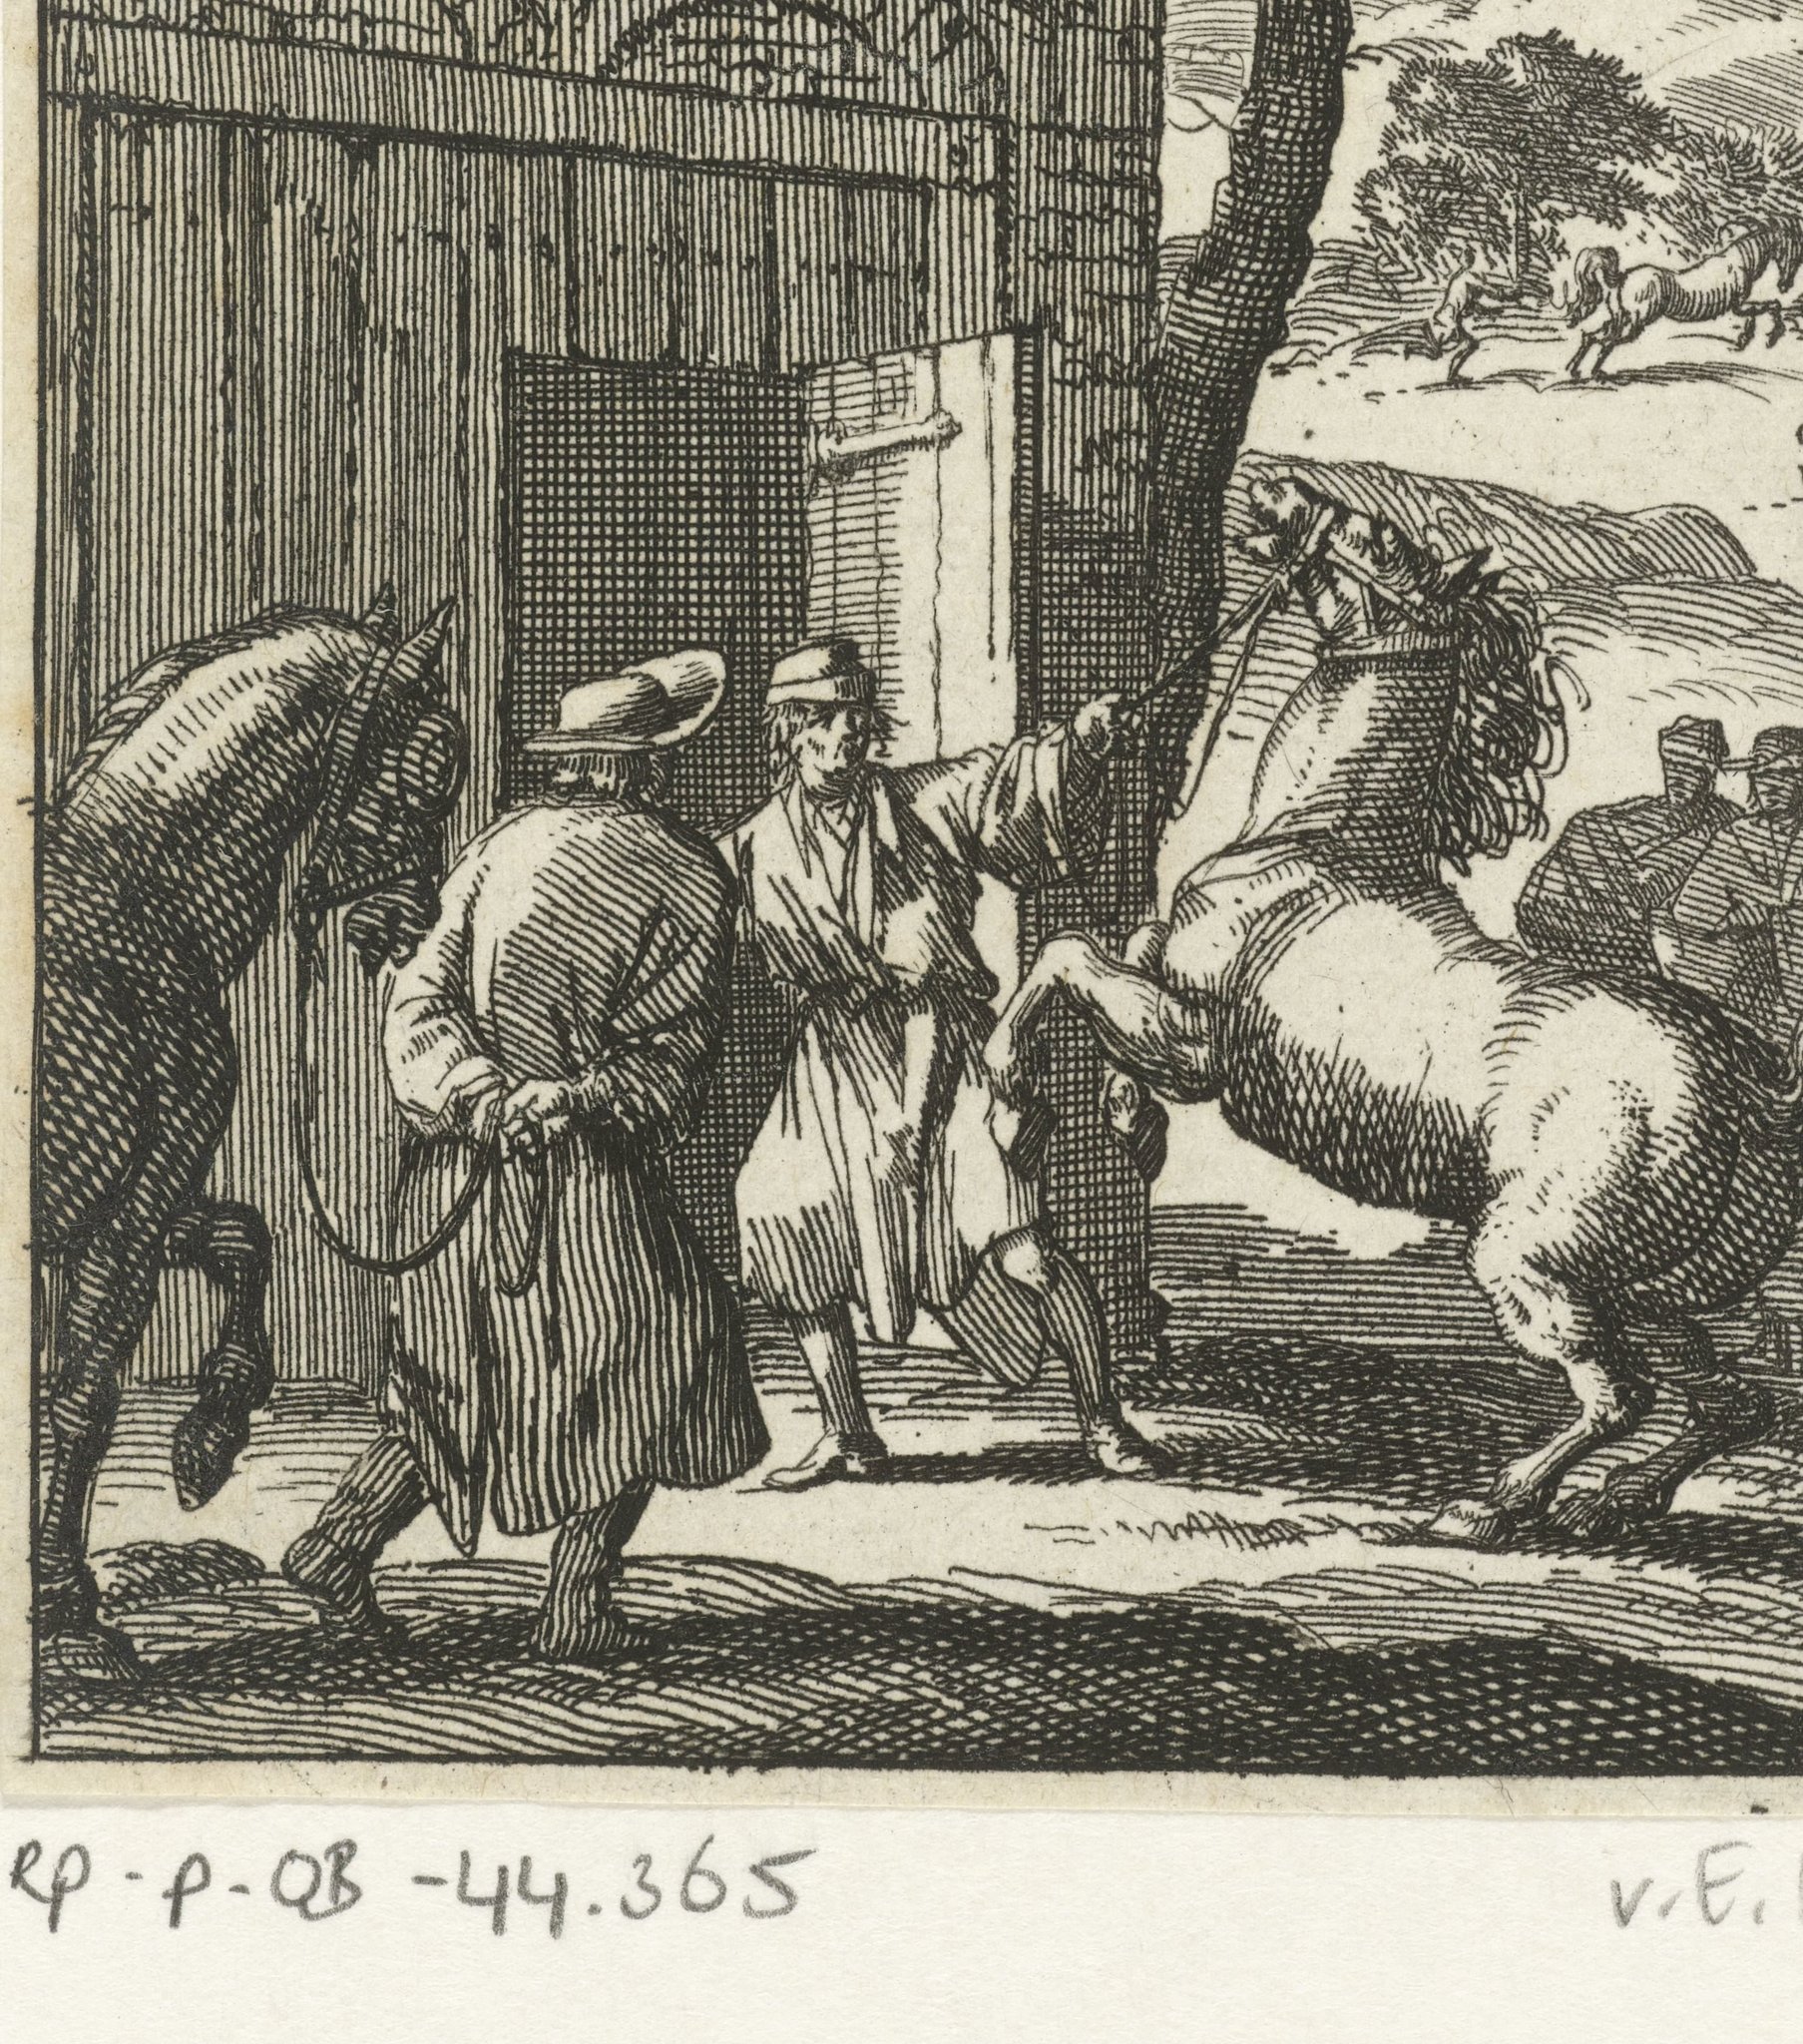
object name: print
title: Man houdt steigerend paard aan de teugels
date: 1689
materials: paper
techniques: etching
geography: amsterdam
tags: rearing (horse in motion)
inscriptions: collector's mark: Lugt 2228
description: Illustratie uit: Huygen, Pieter. De beginselen van Gods koninkryk in den mensch uitgedrukt in zinnebeelden. Amsterdam: wed. Arentsz. Pieter (II), 1689, p. 122.